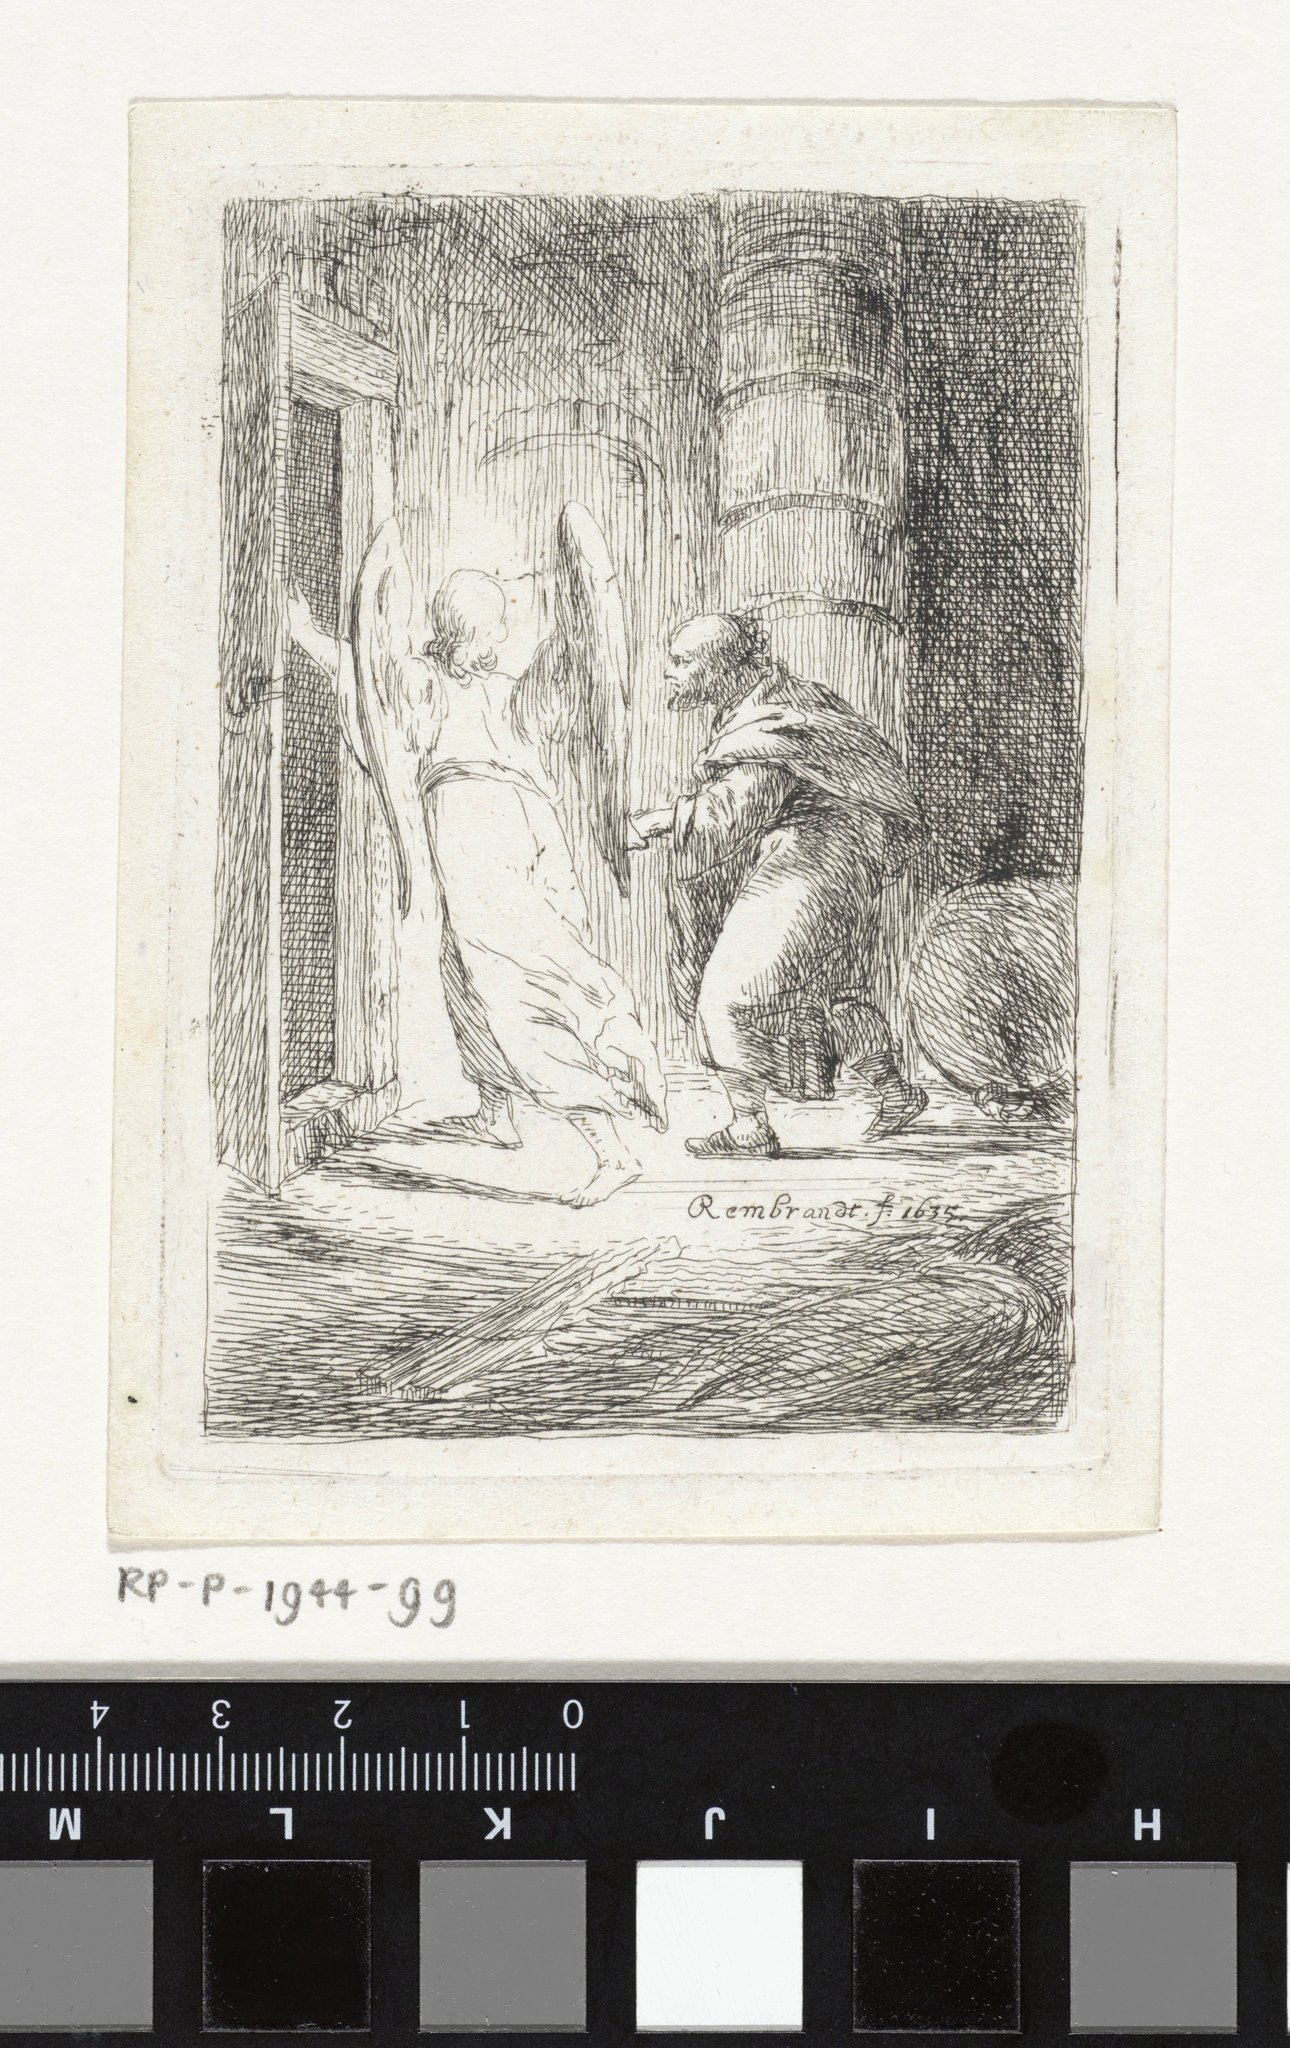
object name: print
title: Man aan de hand van een engel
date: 1635-1719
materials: paper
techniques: etching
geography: northern netherlands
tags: housing, old man, angels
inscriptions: collector's mark: Lugt 240, collector's mark: Lugt 2228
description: Een engel leidt een oude man in de richting van een geopende deur.